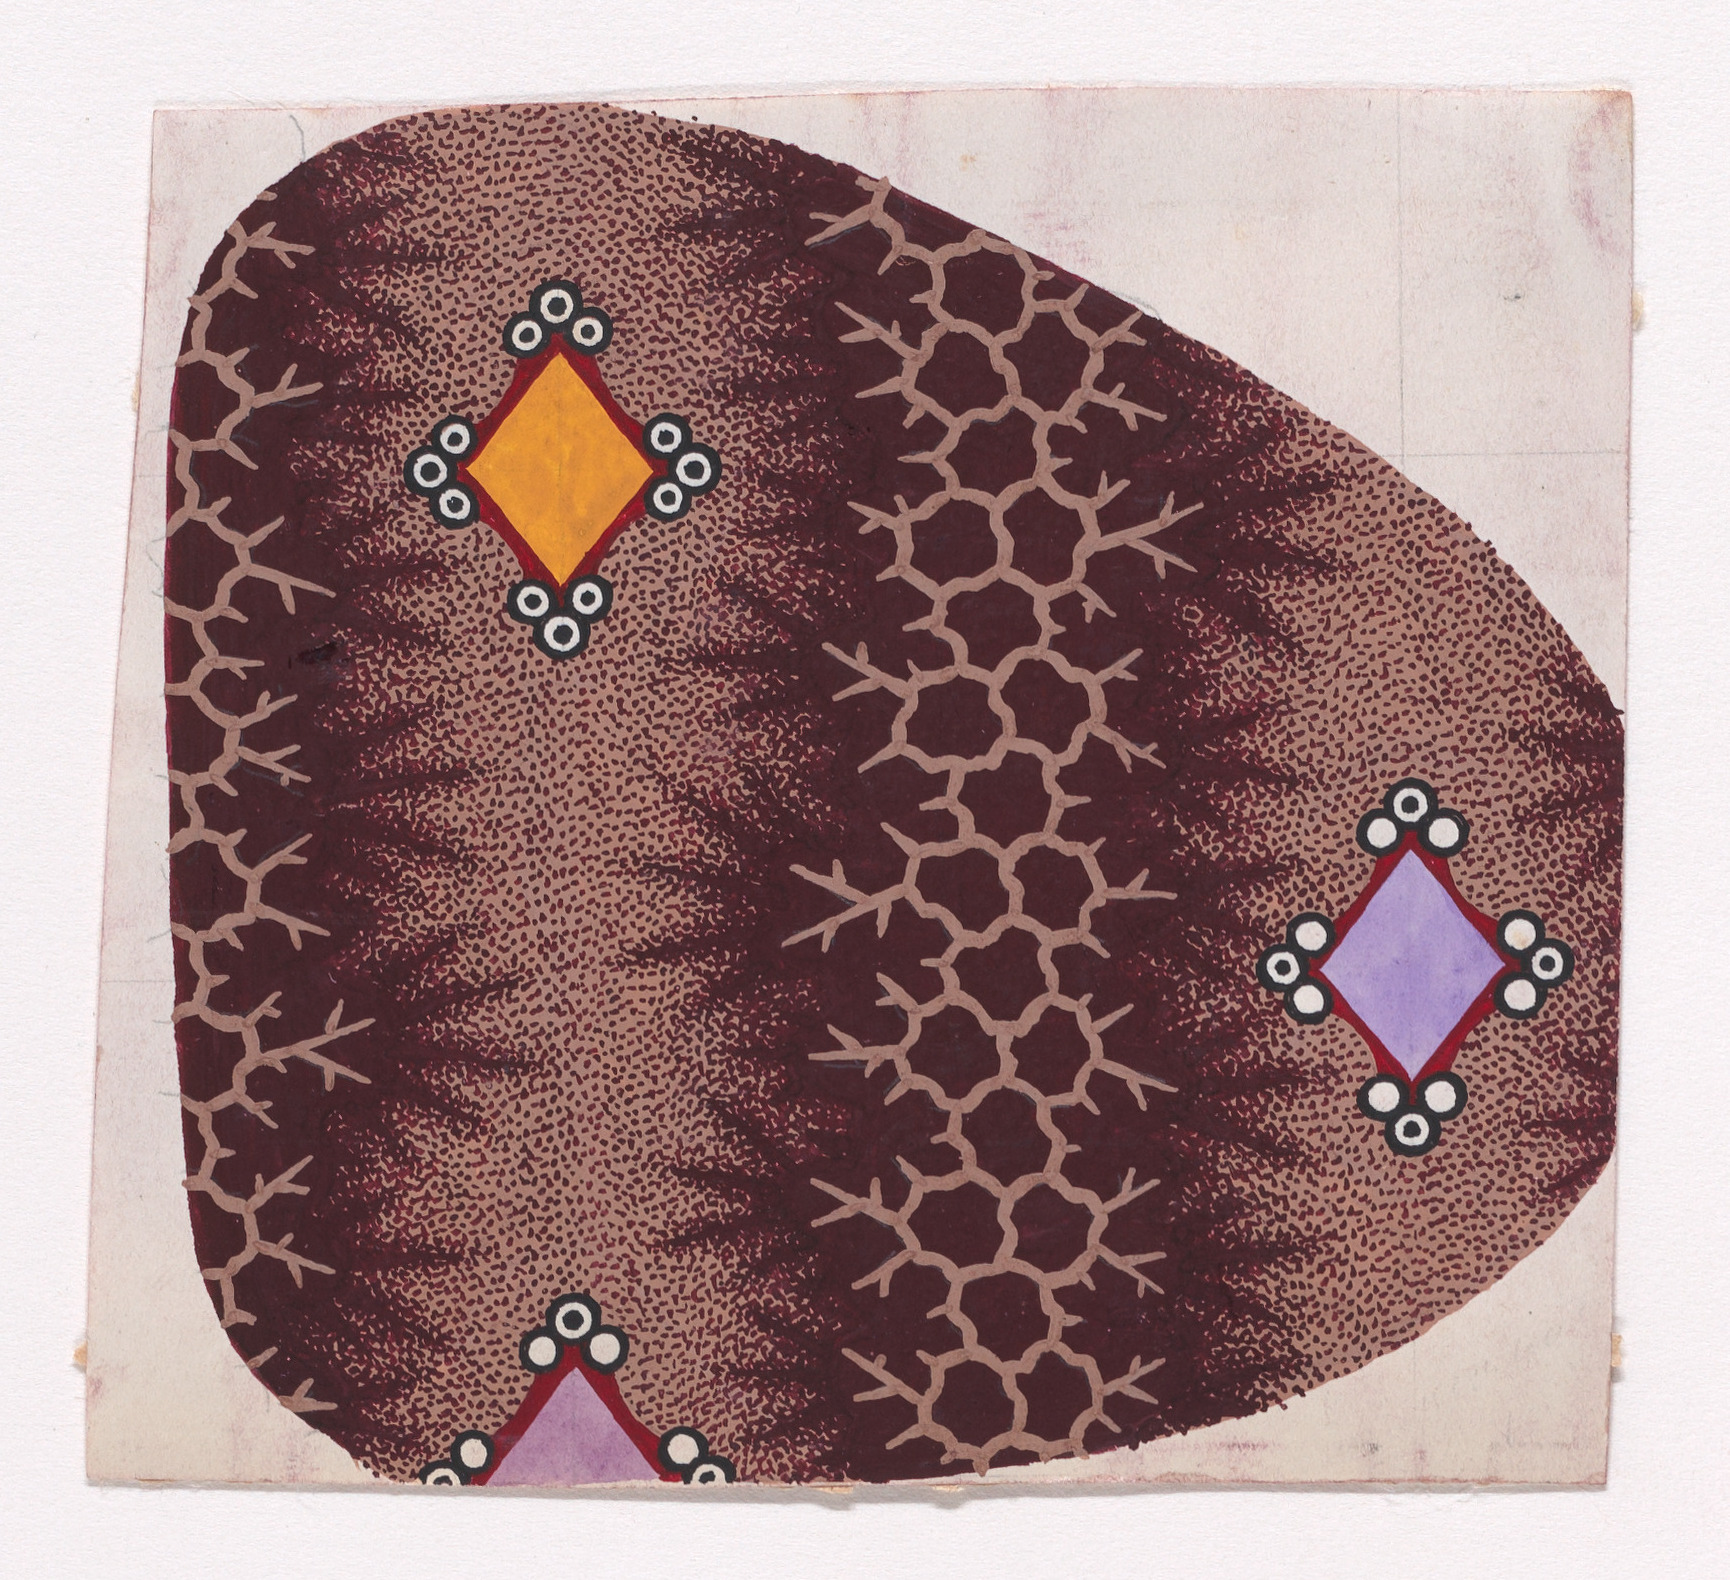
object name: drawing ornament architecture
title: Textile Design with Alternating Vertical Stripes of Lozenges with Pearls in the Vertices and Abstract Organic Honeycomb Structures with Branch Offshoots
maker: anonymous, alsatian, 19th century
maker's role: artist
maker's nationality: alsatian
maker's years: 1800-1900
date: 1840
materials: gouache